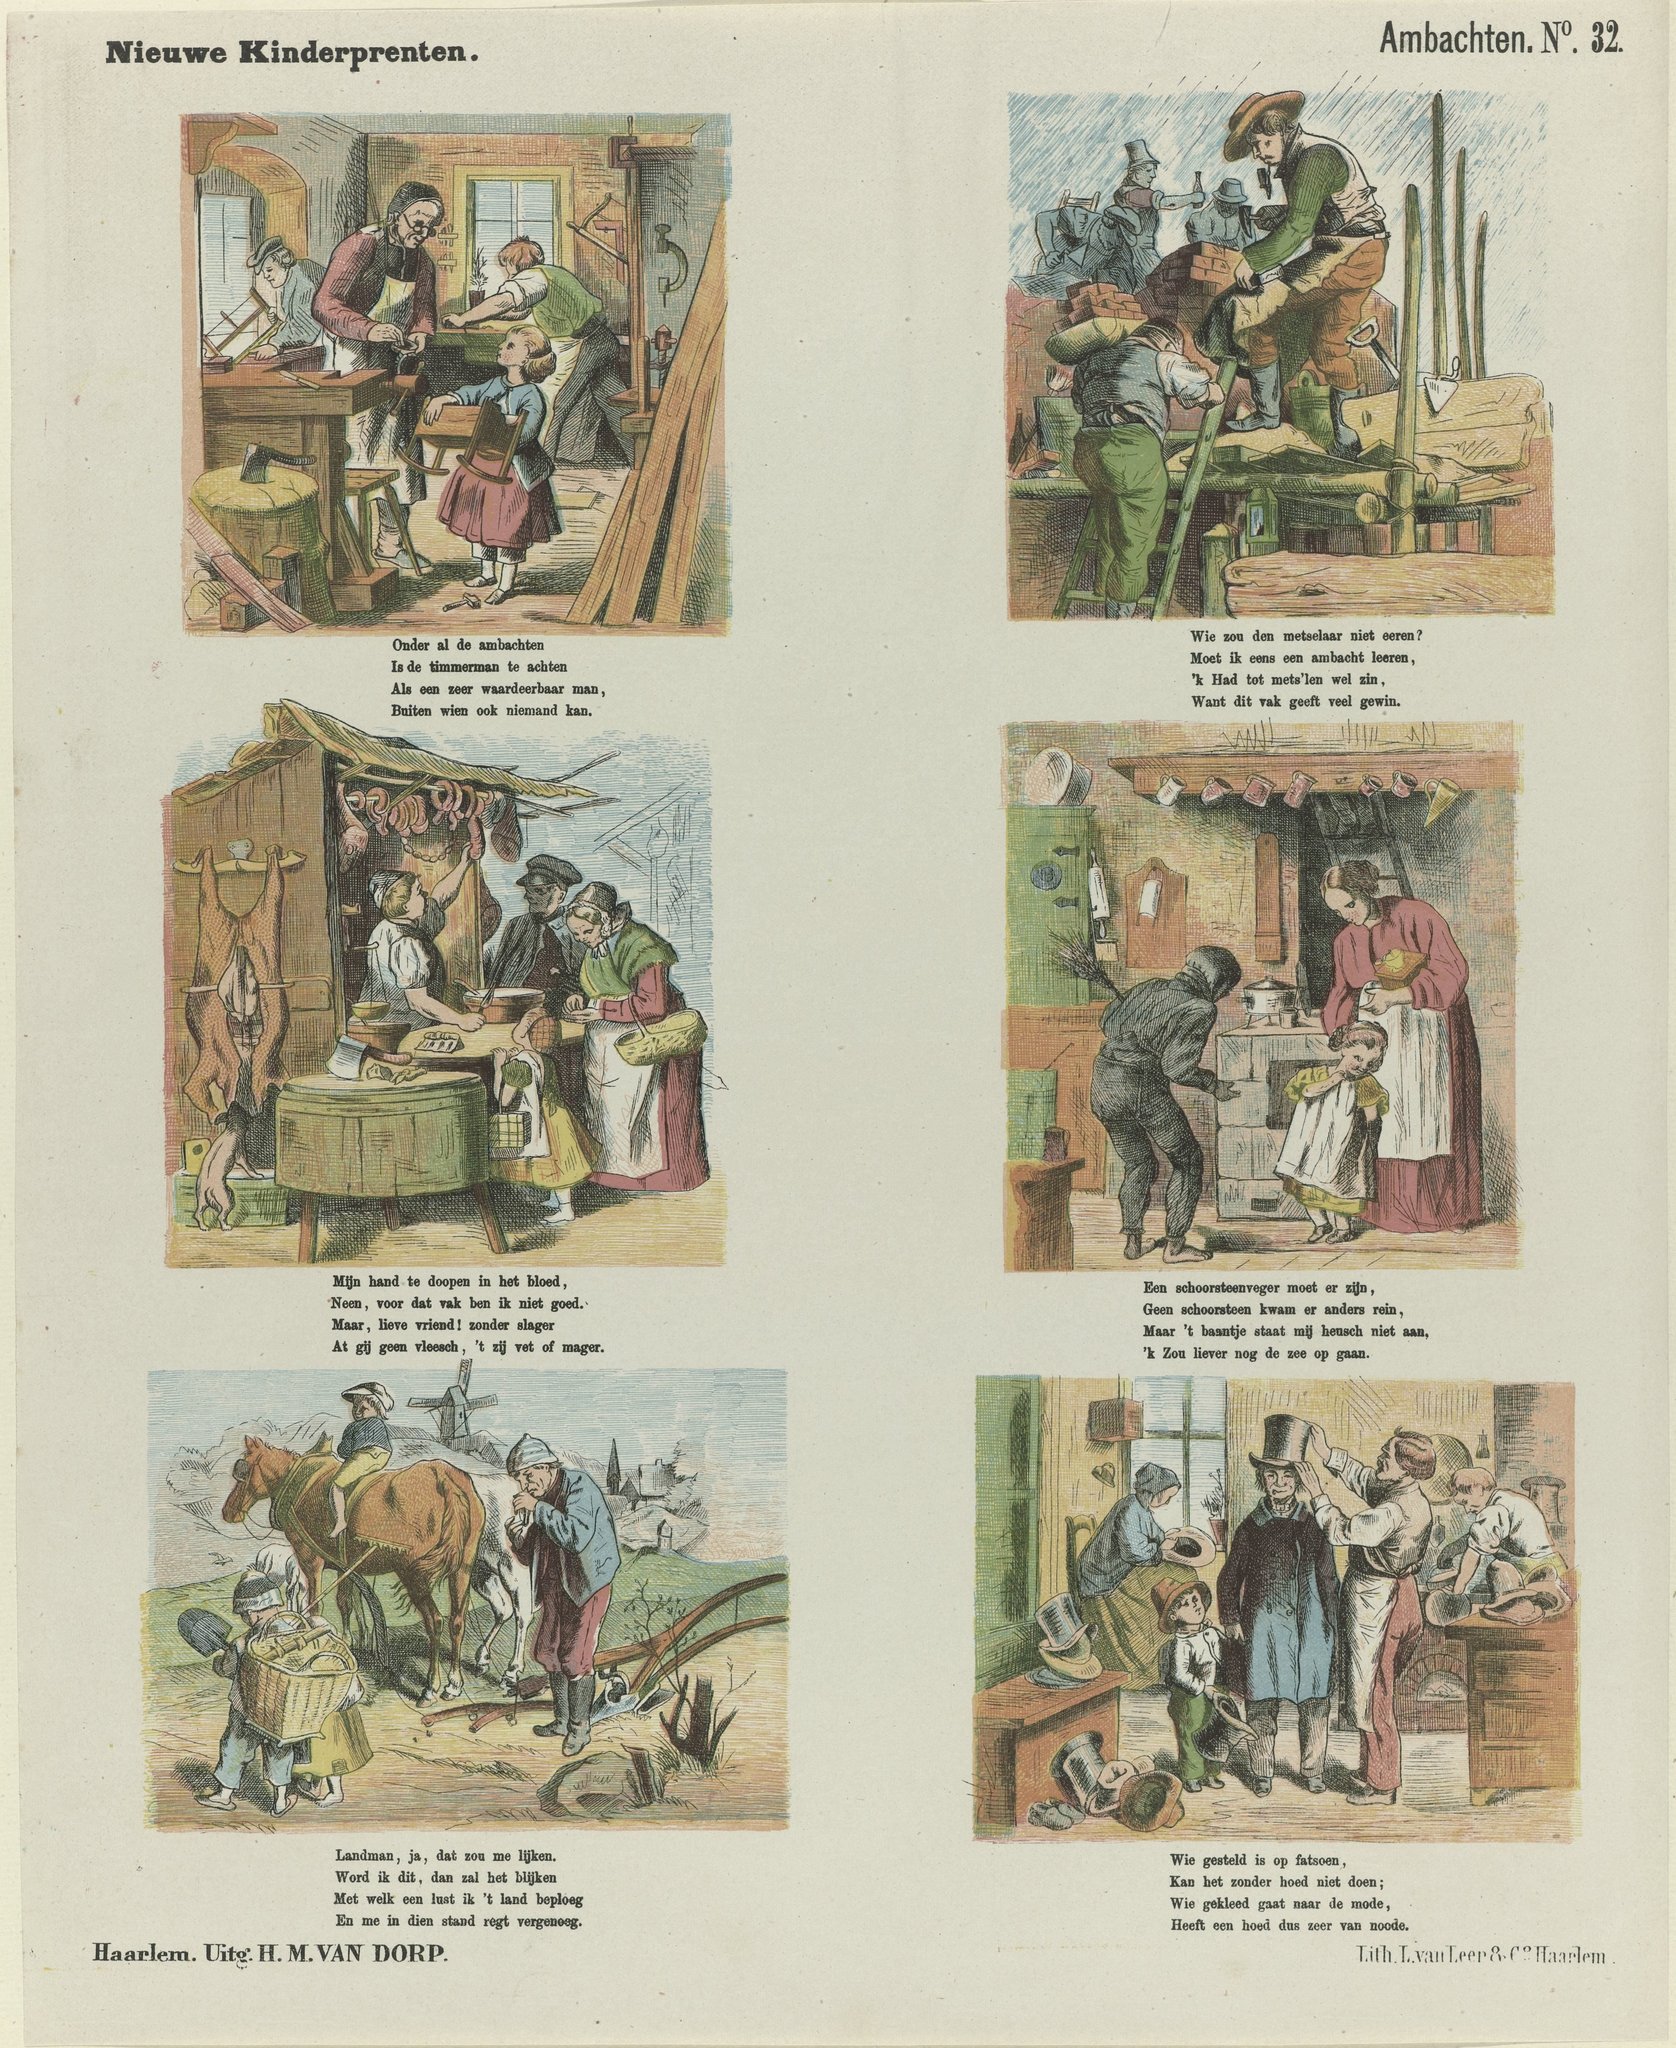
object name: popular print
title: Ambachten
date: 1872-1883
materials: paper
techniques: lithograph, letterpress printing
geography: haarlem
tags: carpenter, craft-production, skilled handiwork, handicrafts ~ maintenance and repair (with name of trade or profession), mason at work, crafts and industries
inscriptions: collector's mark: Lugt 2760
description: Blad met 6 voorstellingen van ambachtslieden en beroepen, zoals timmerman, schoorsteenveger en hoedenmaker. Onder elke afbeelding een vierregelig vers. Genummerd rechtsboven: No. 32.